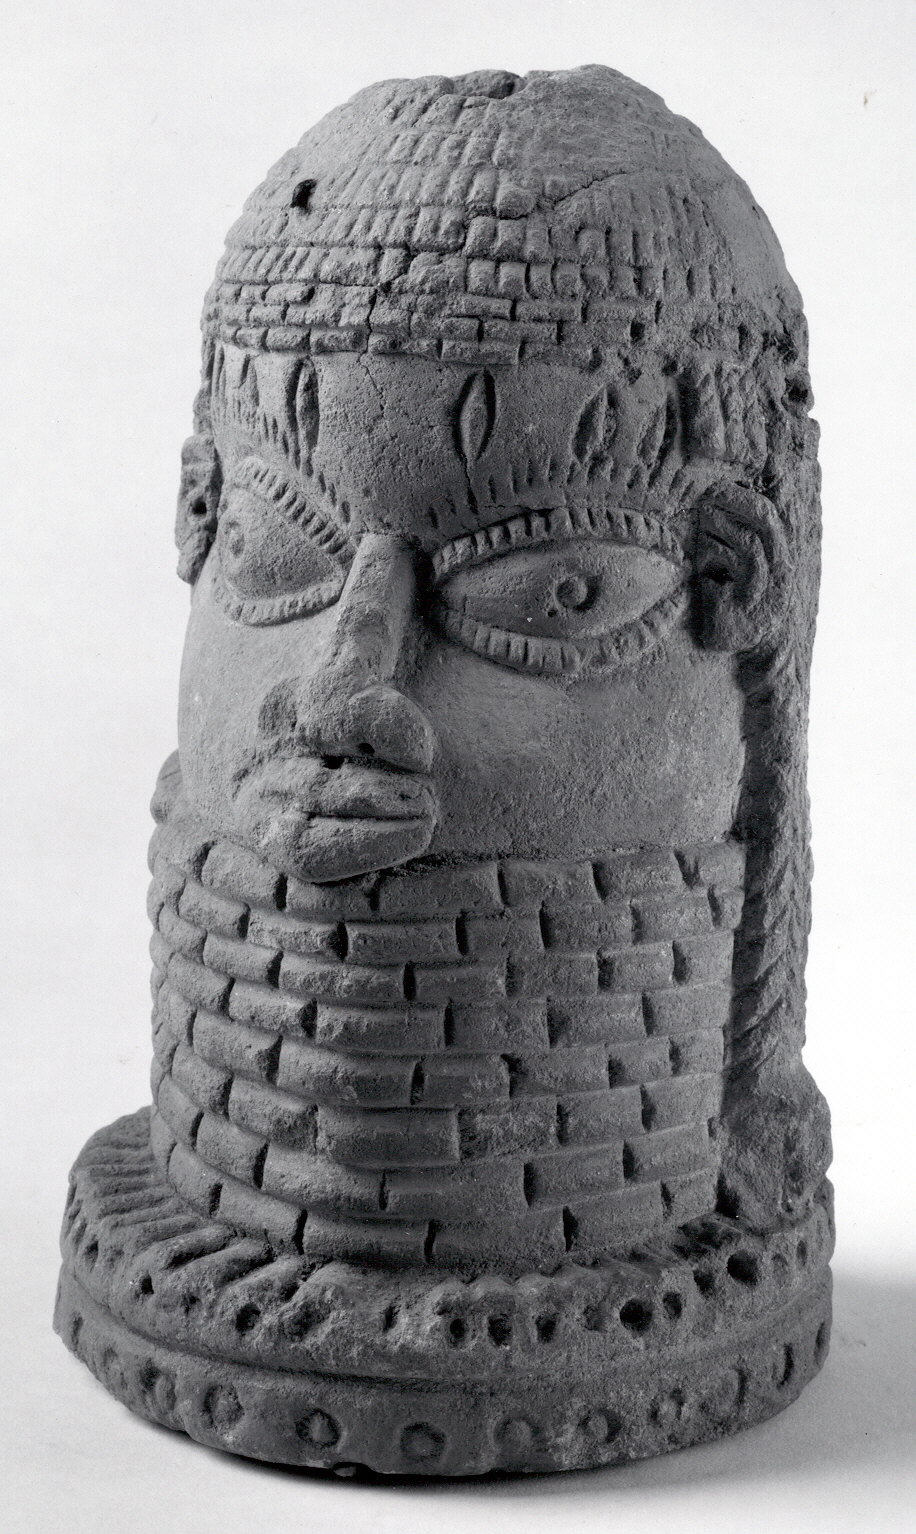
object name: head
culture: edo period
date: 1801-1900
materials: terracotta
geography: nigeria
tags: heads